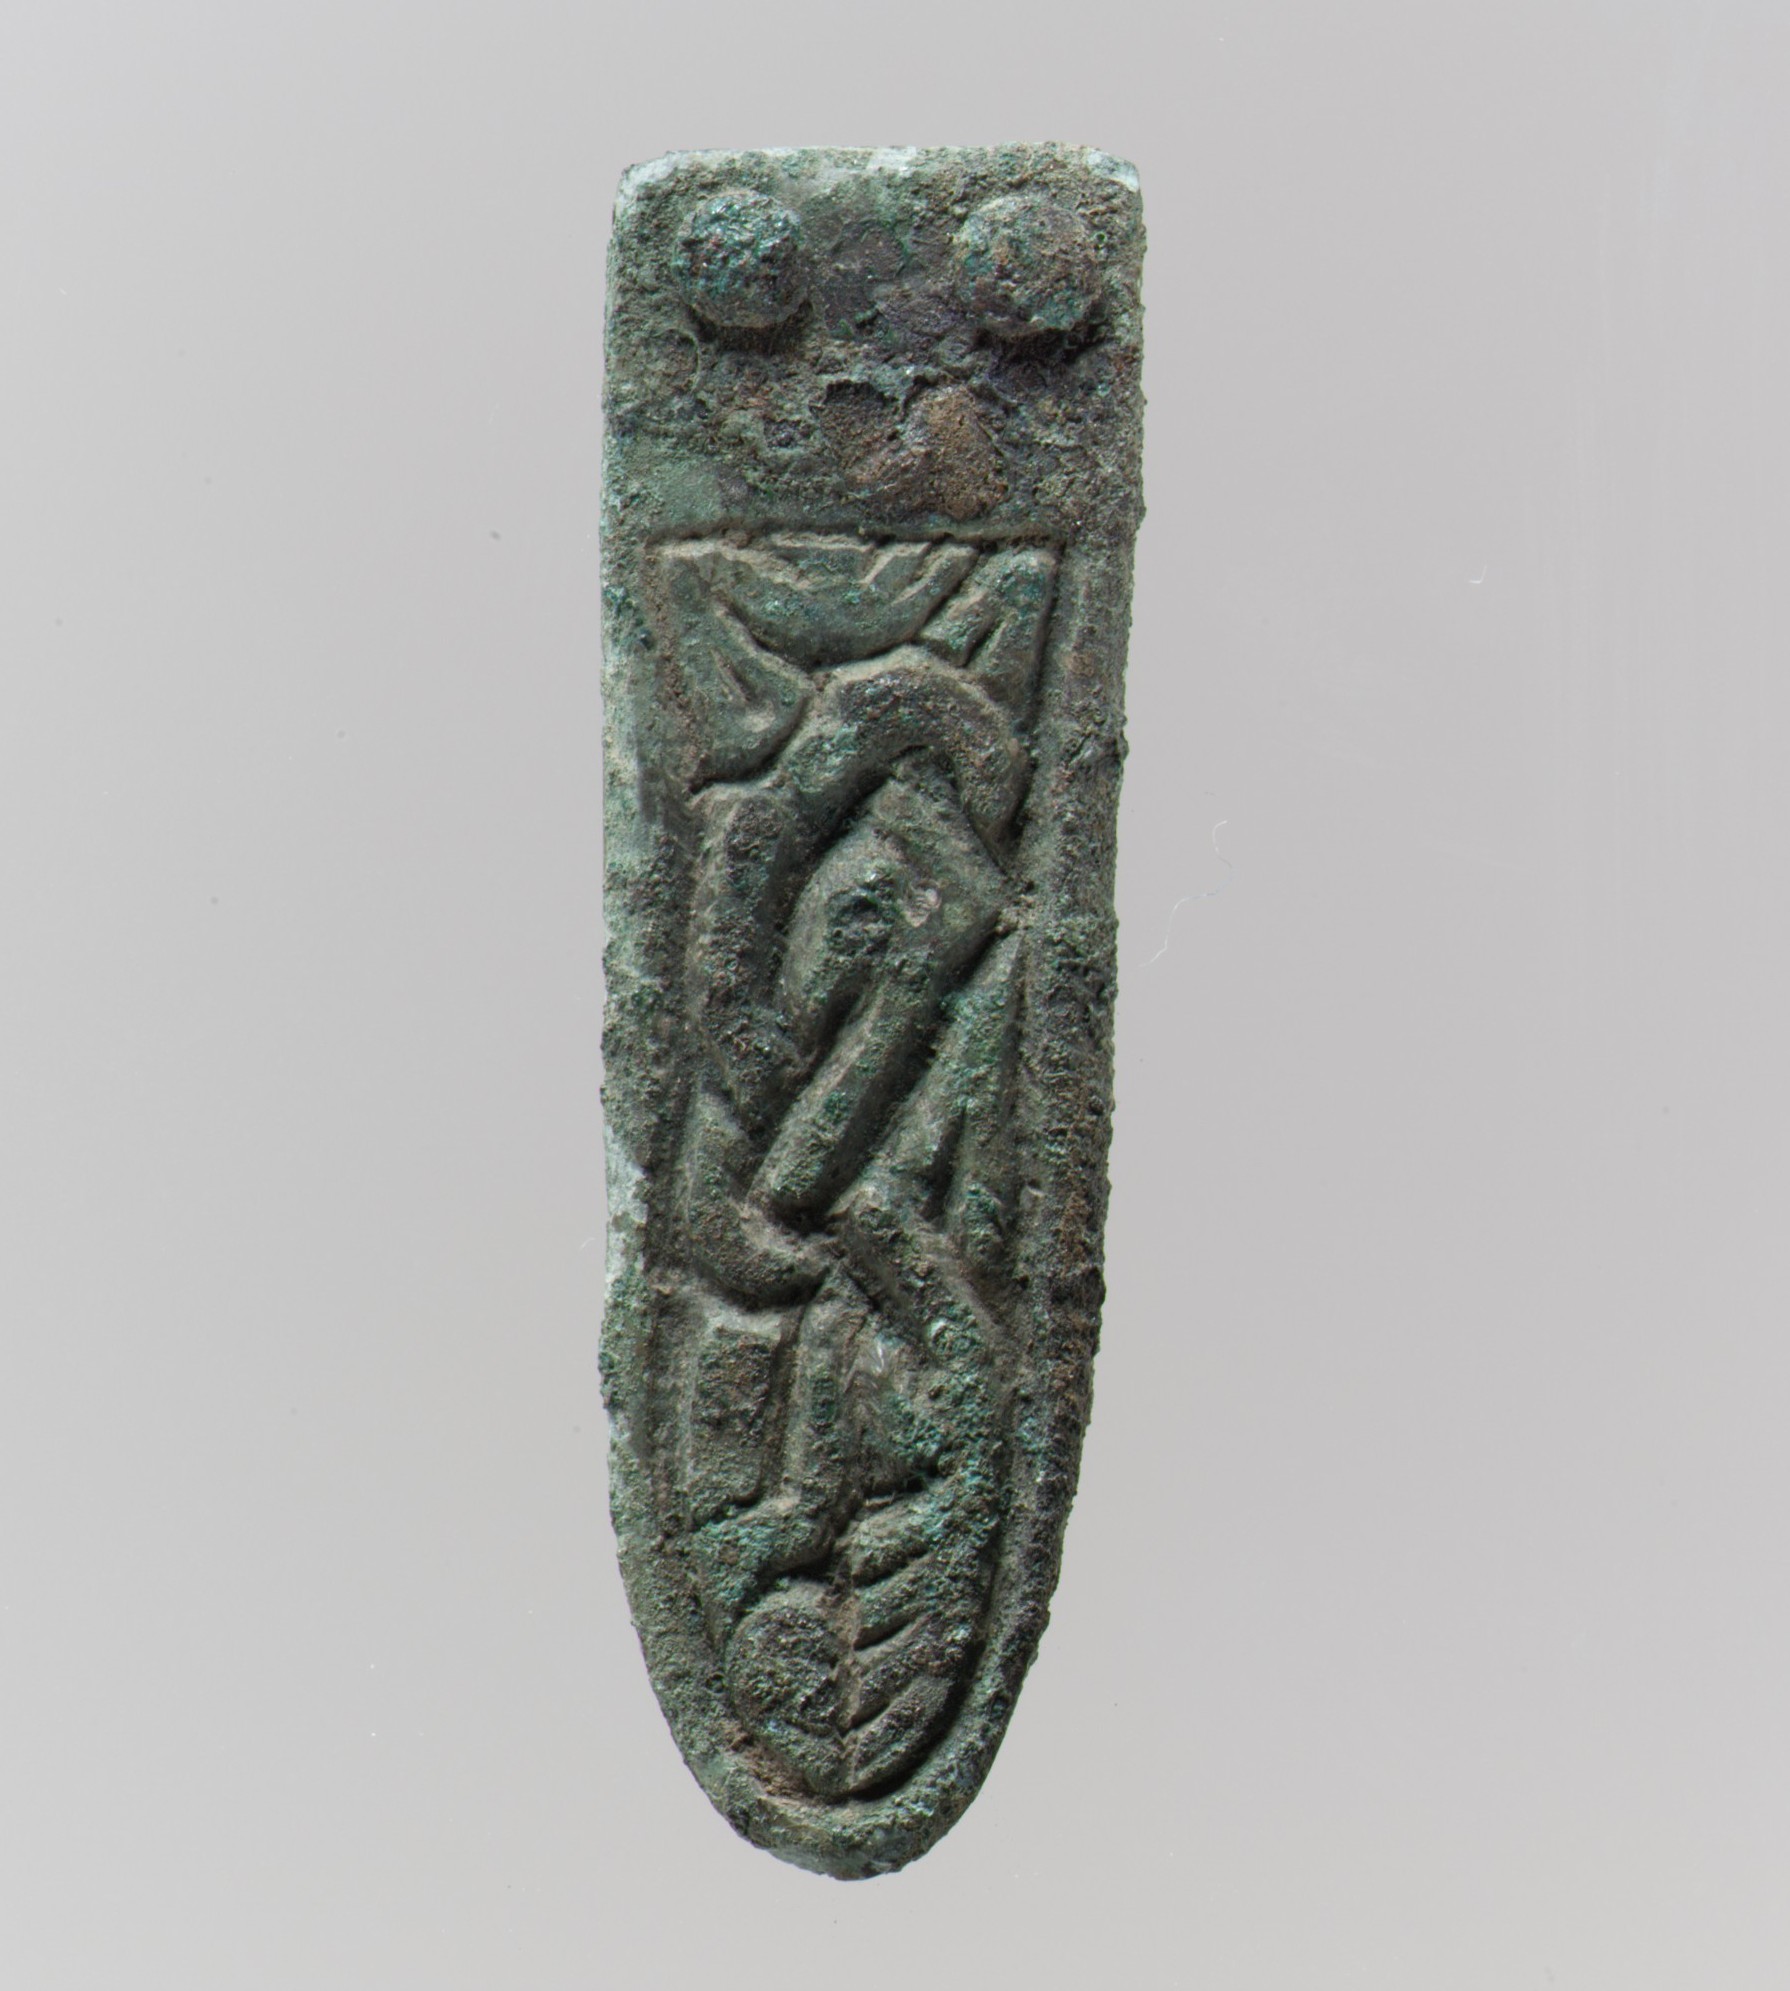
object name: strap end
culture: frankish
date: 601-700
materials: copper alloy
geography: germany